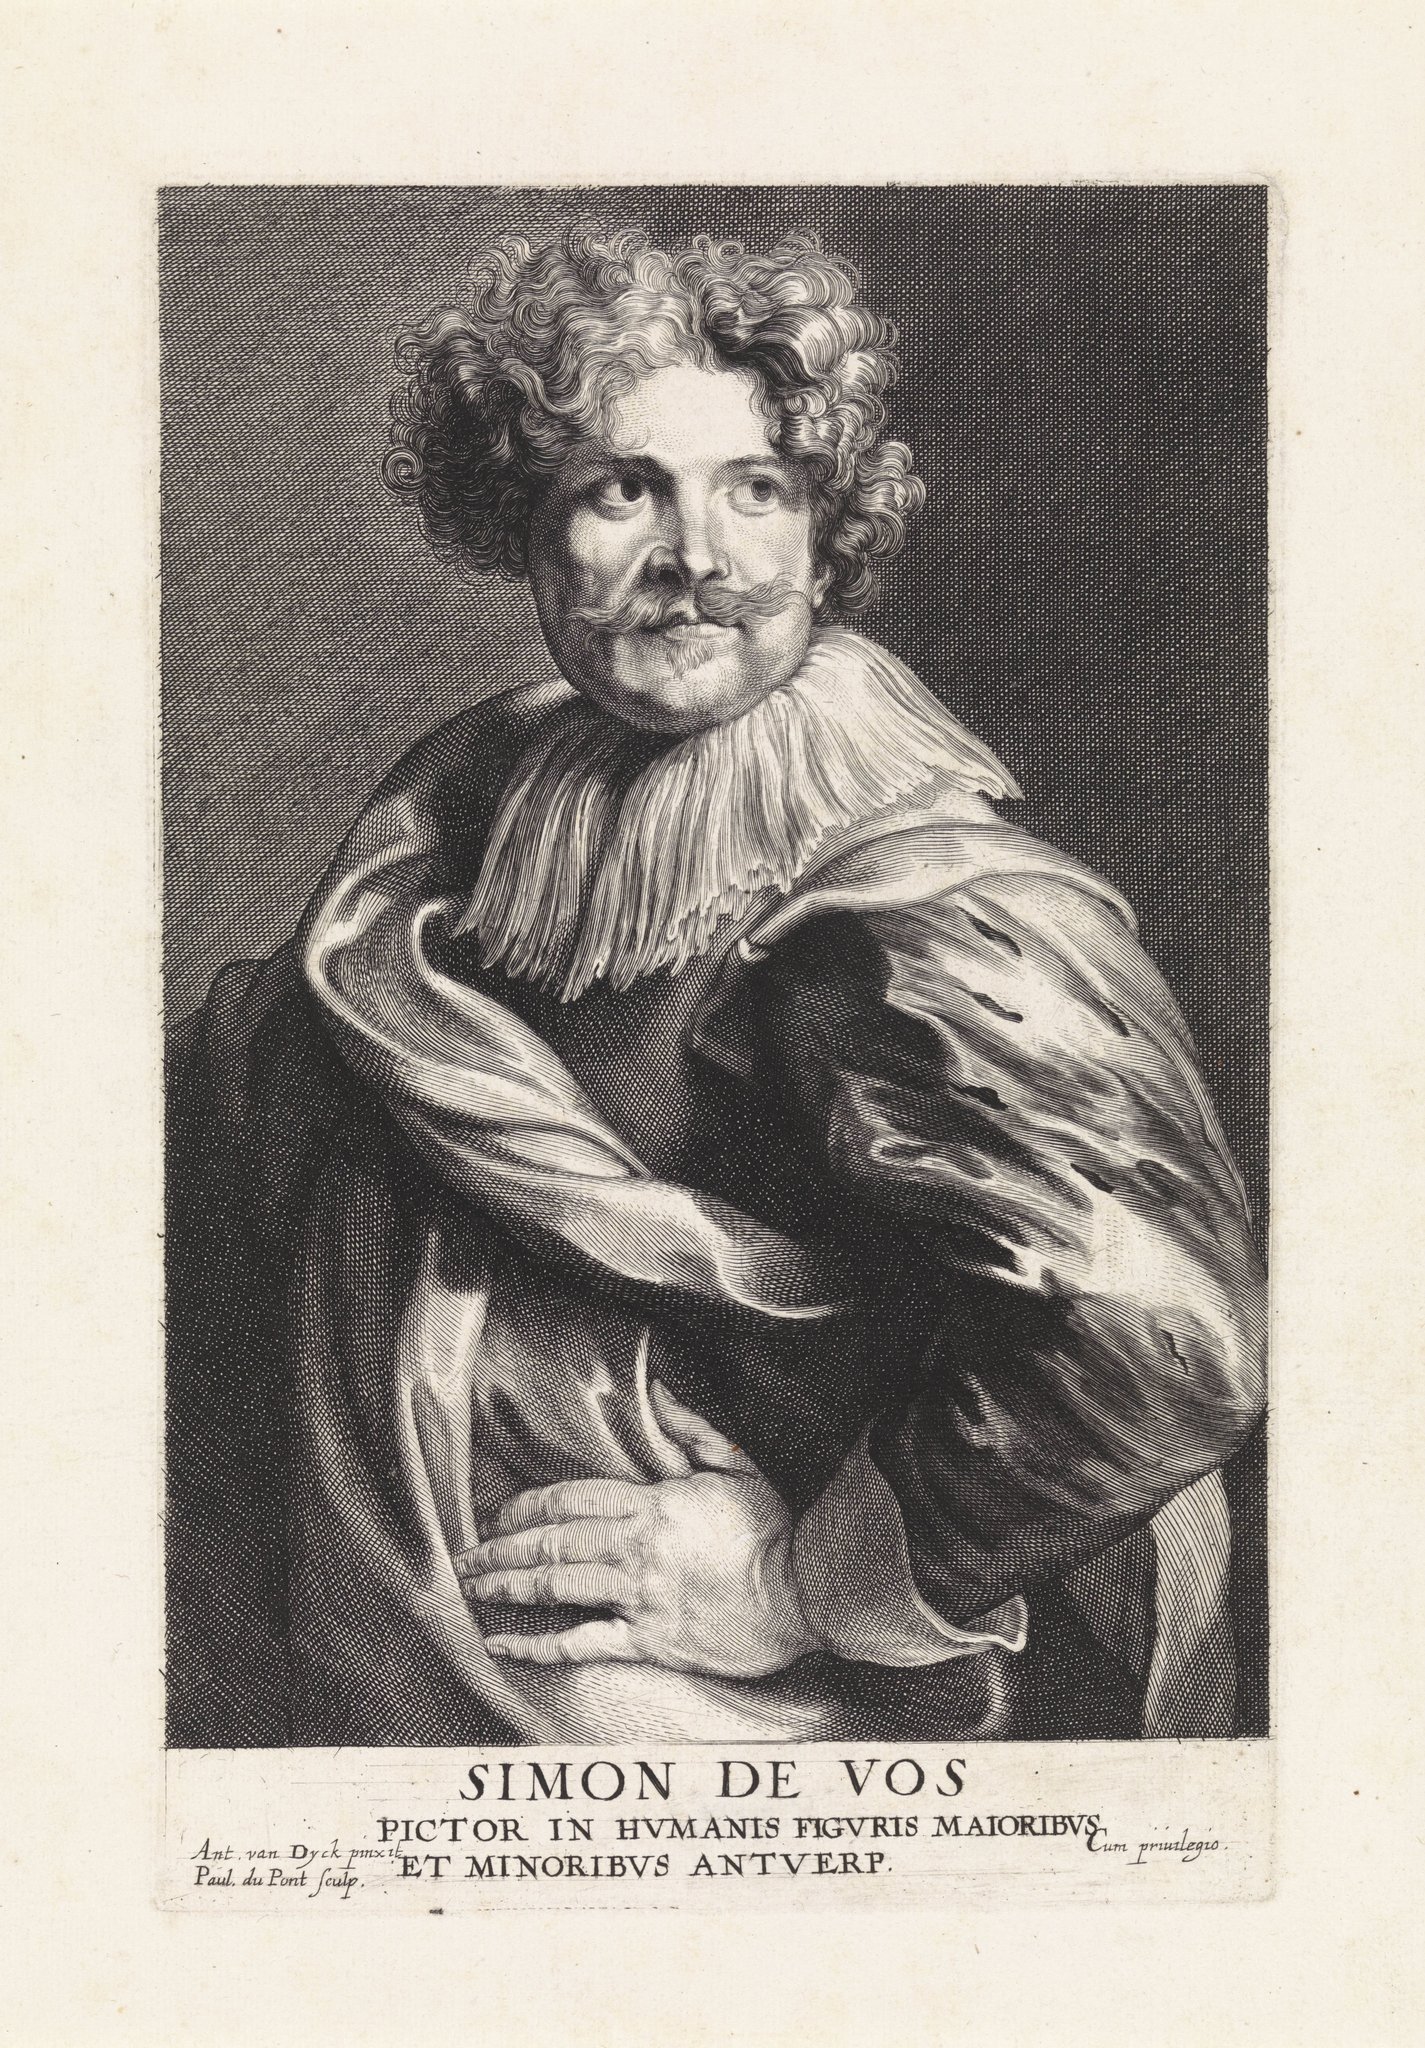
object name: print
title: Portret van de schilder Simon de Vos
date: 1616-1657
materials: paper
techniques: engraving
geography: antwerp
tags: painter, portrait, self-portrait of painter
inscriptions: collector's mark: Lugt 906, collector's mark: Lugt 2228, collector's mark: Lugt 654